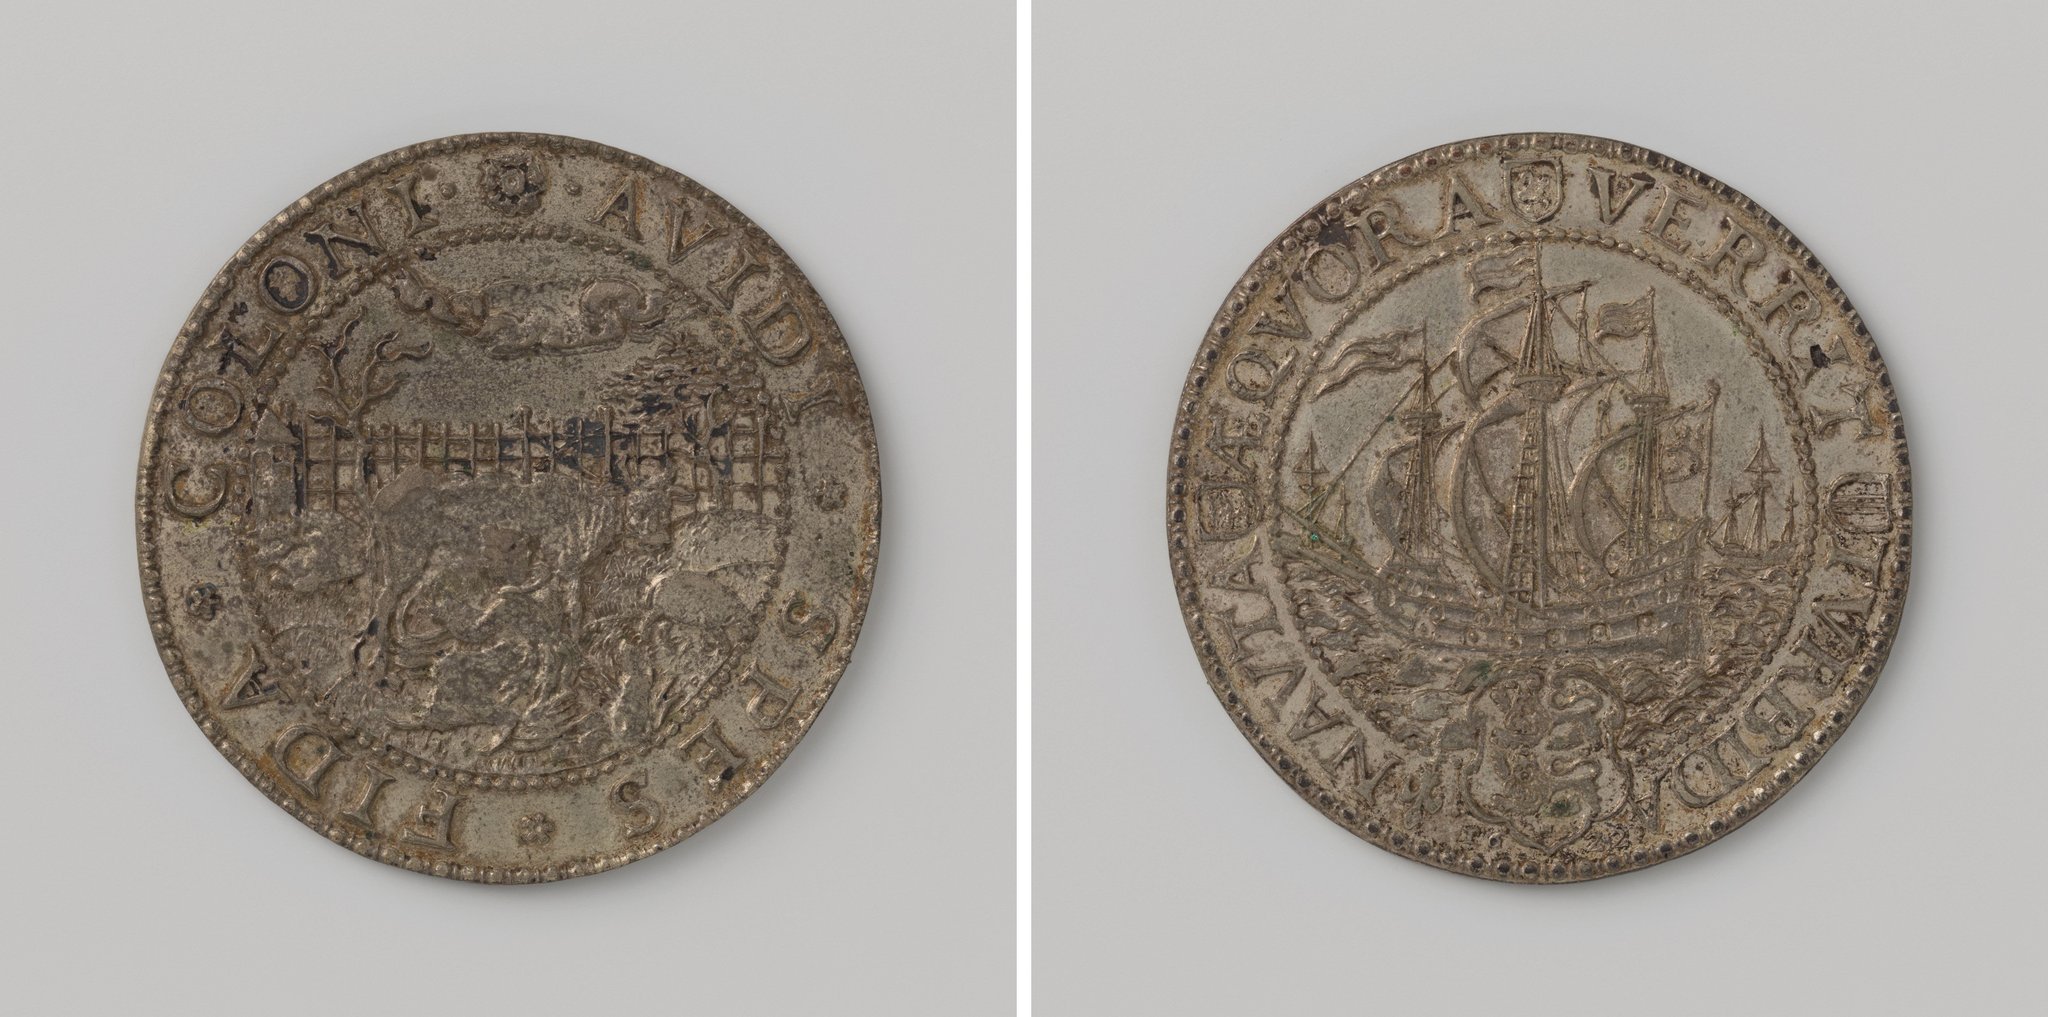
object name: history medal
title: Voorspoed van West-Friesland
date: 1617-1622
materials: silver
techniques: striking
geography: west frisia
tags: west-friesland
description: Zilveren penning. Voorzijde: vrouw die koe melkt binnen omschrift. Keerzijde: koopvaardijschip binnen rand met omschrift en vier wapenschilden